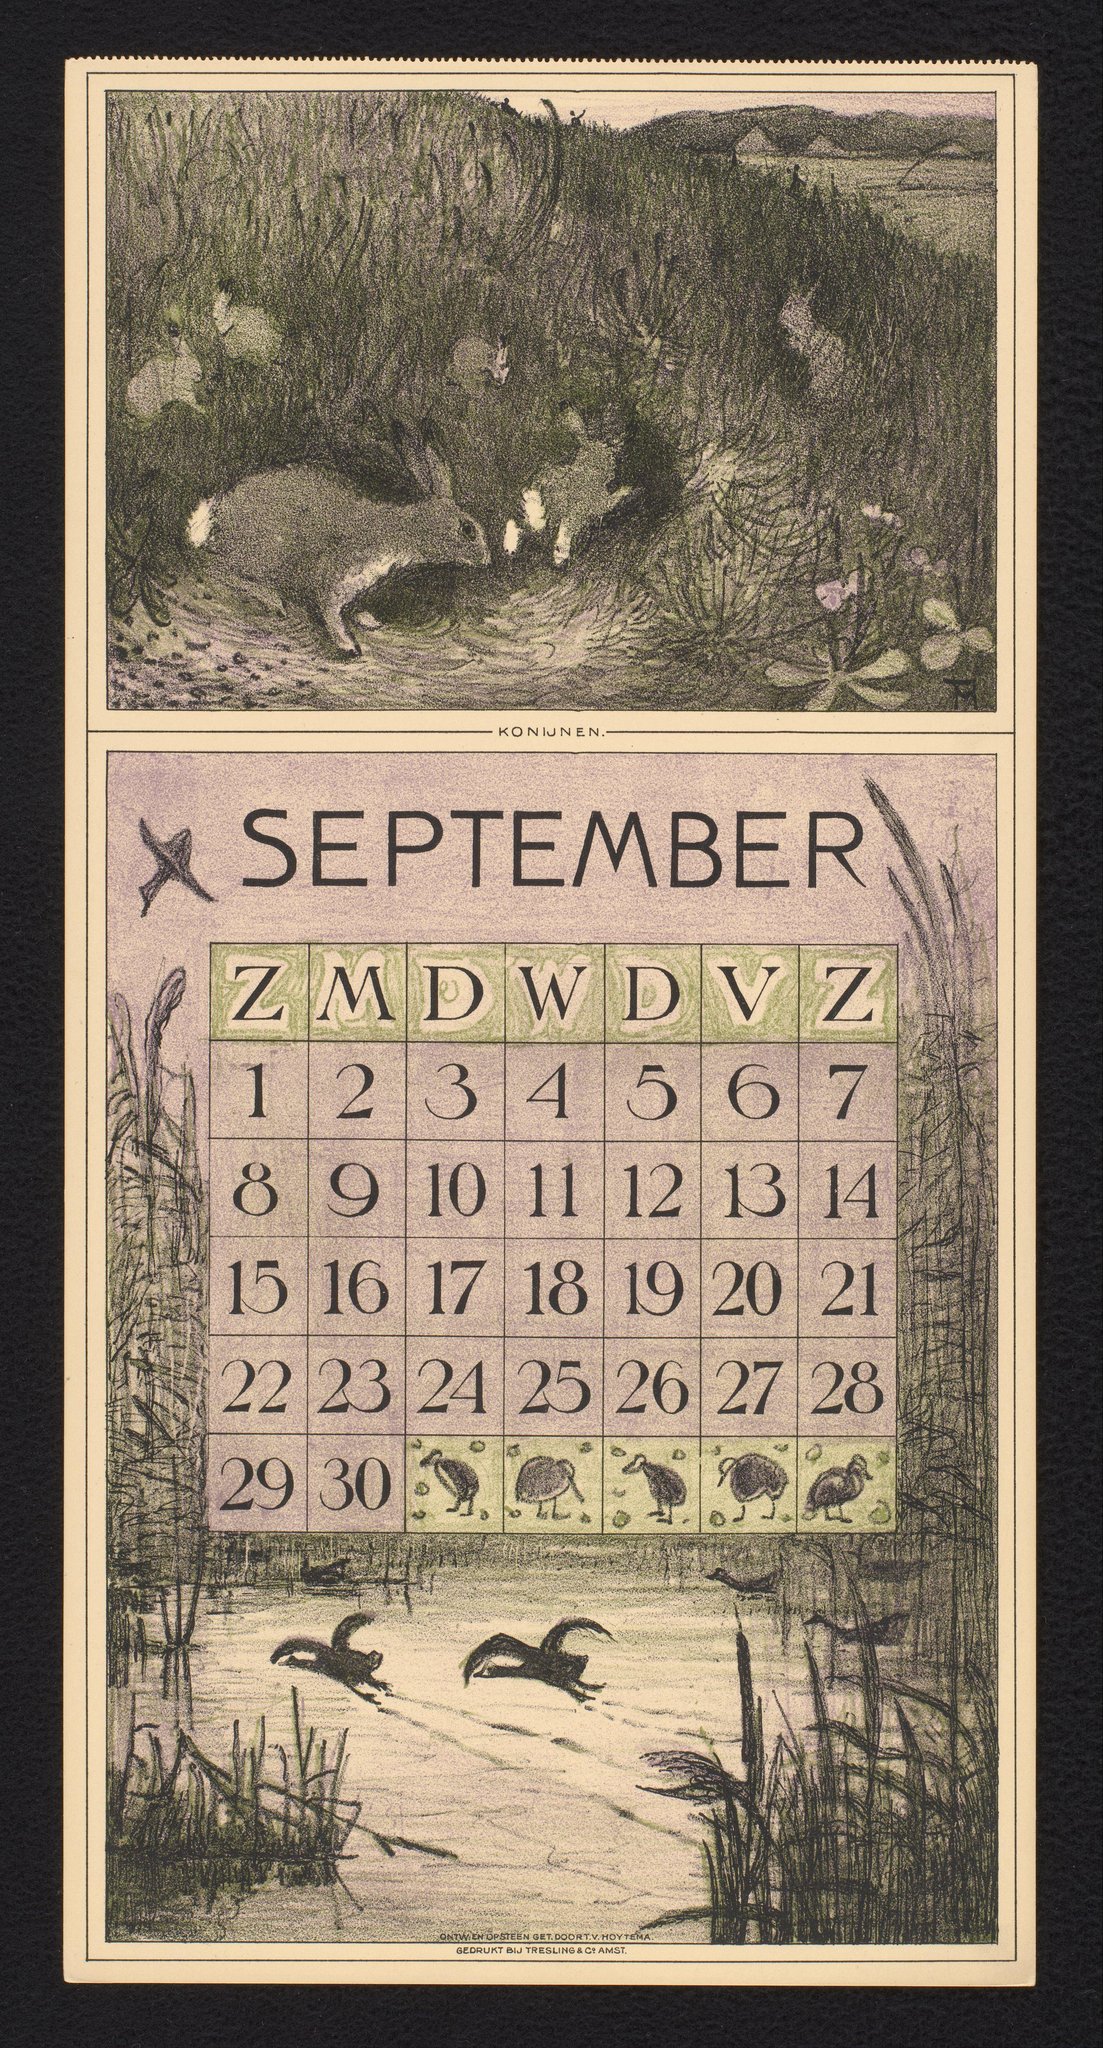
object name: calendar leaf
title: Kalenderblad voor september 1912 met konijnen en meerkoeten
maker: theo van hoytema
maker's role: draughtsman, painter, print maker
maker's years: 1863-1917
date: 1911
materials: paper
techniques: lithograph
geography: amsterdam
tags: water-birds: coot, rodents: rabbit